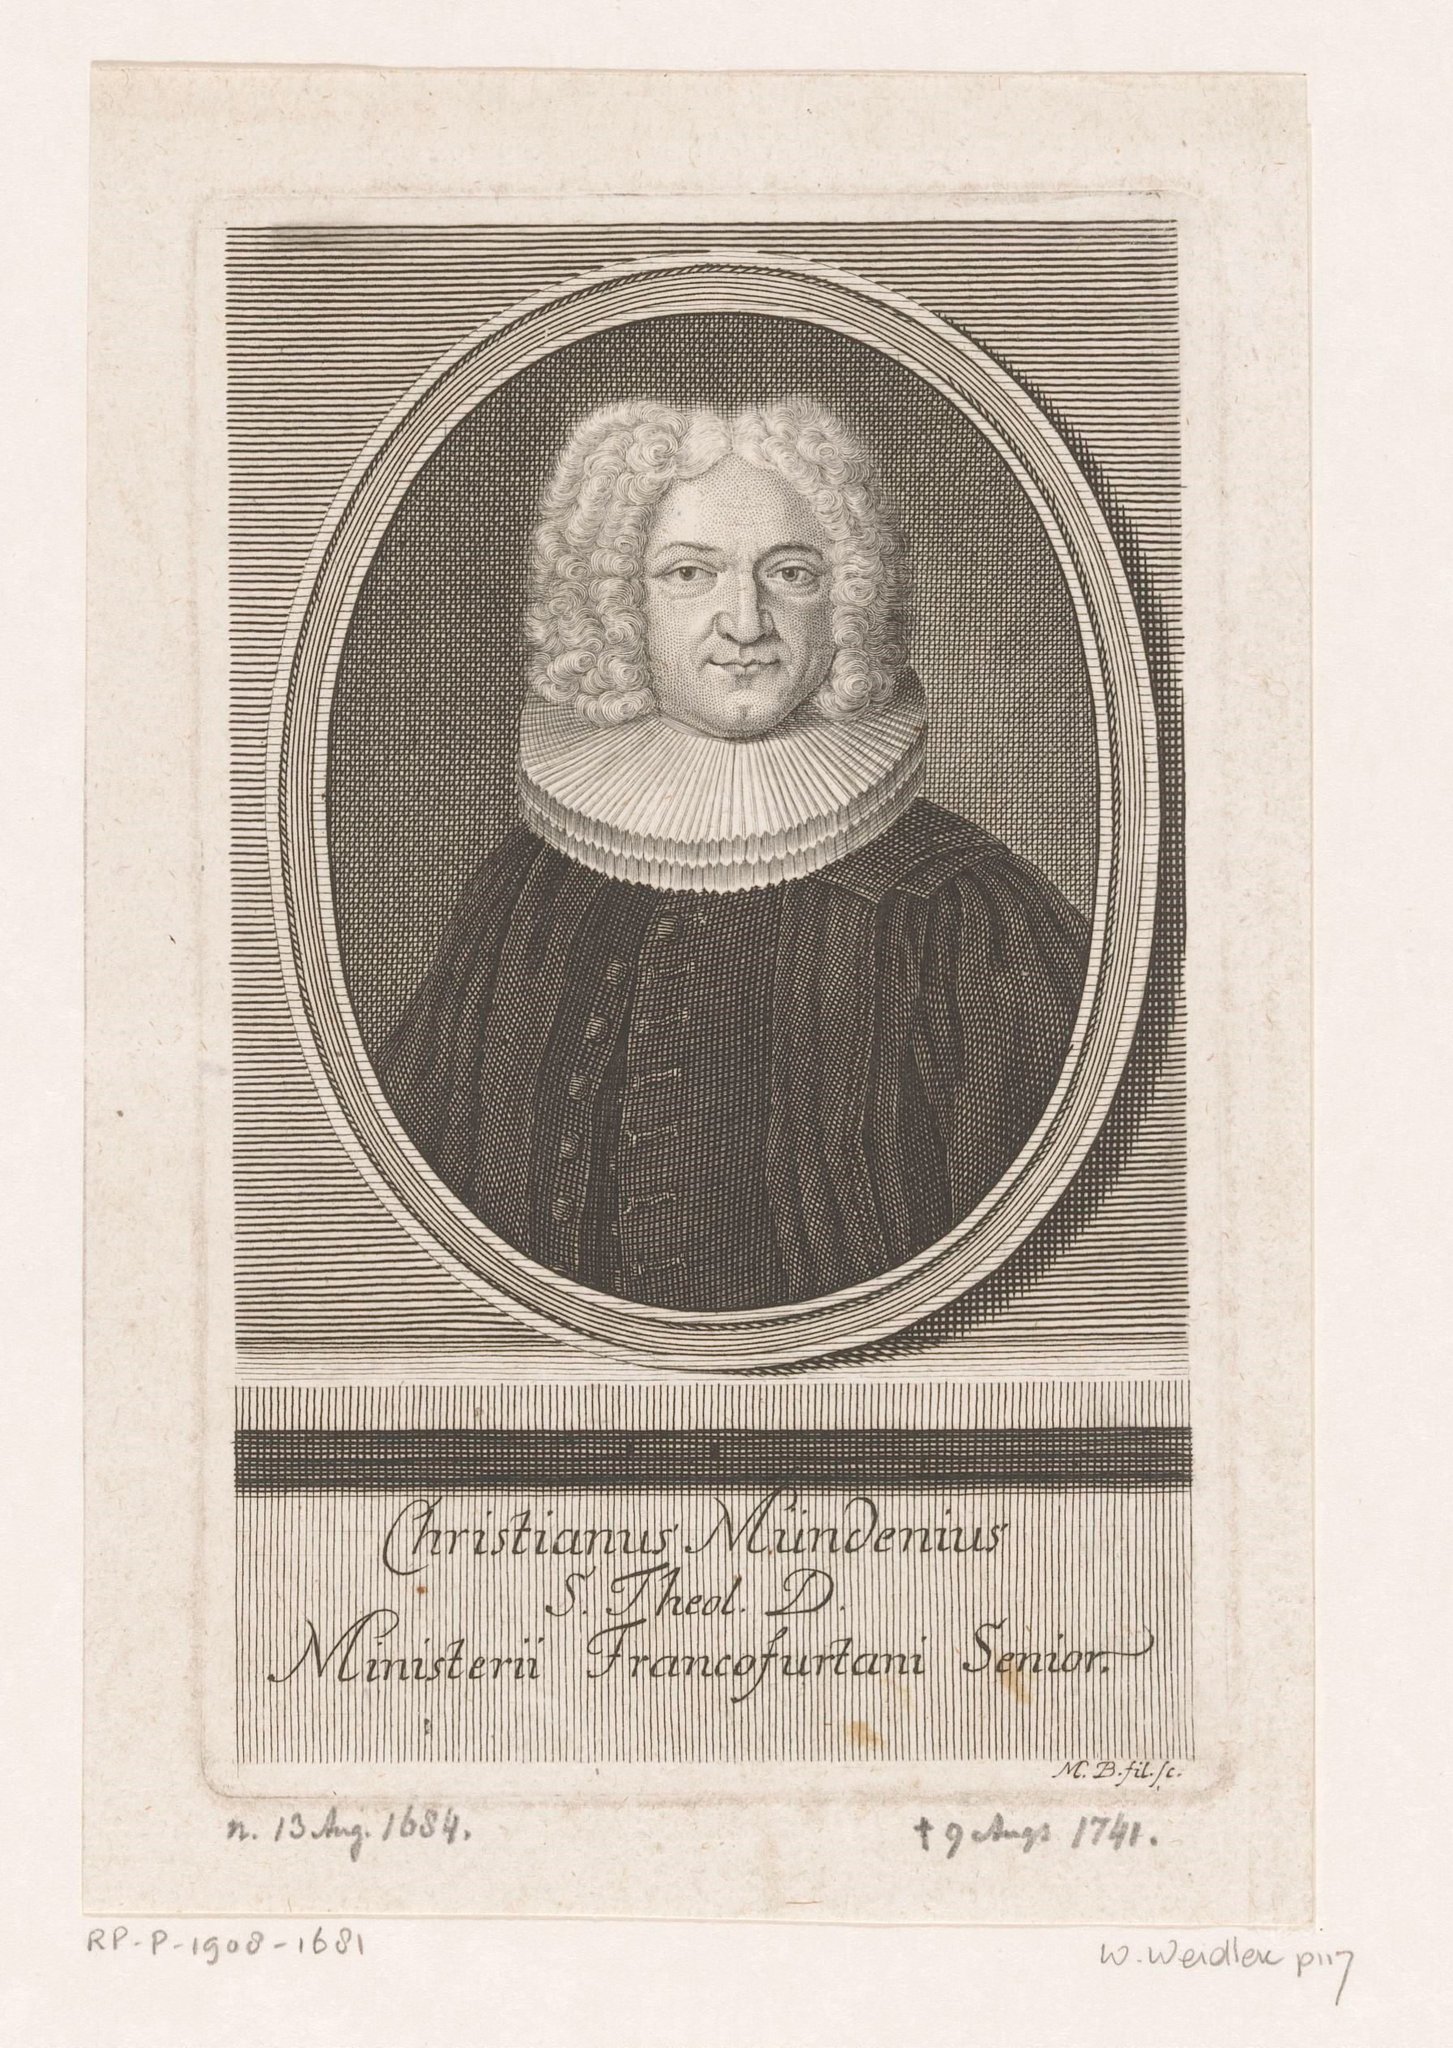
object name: print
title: Portret van Christian Münden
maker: johann martin bernigeroth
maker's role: print maker, publisher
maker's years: 1713-1767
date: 1734-1767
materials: paper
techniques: engraving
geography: leipzig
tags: historical persons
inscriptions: collector's mark: Lugt 2228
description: Prent ook gebruikt in: Deutsche Acta Eruditorum (...). dl. 180. Leipzig: Johann Gottlieb Gleditsch, 1734.